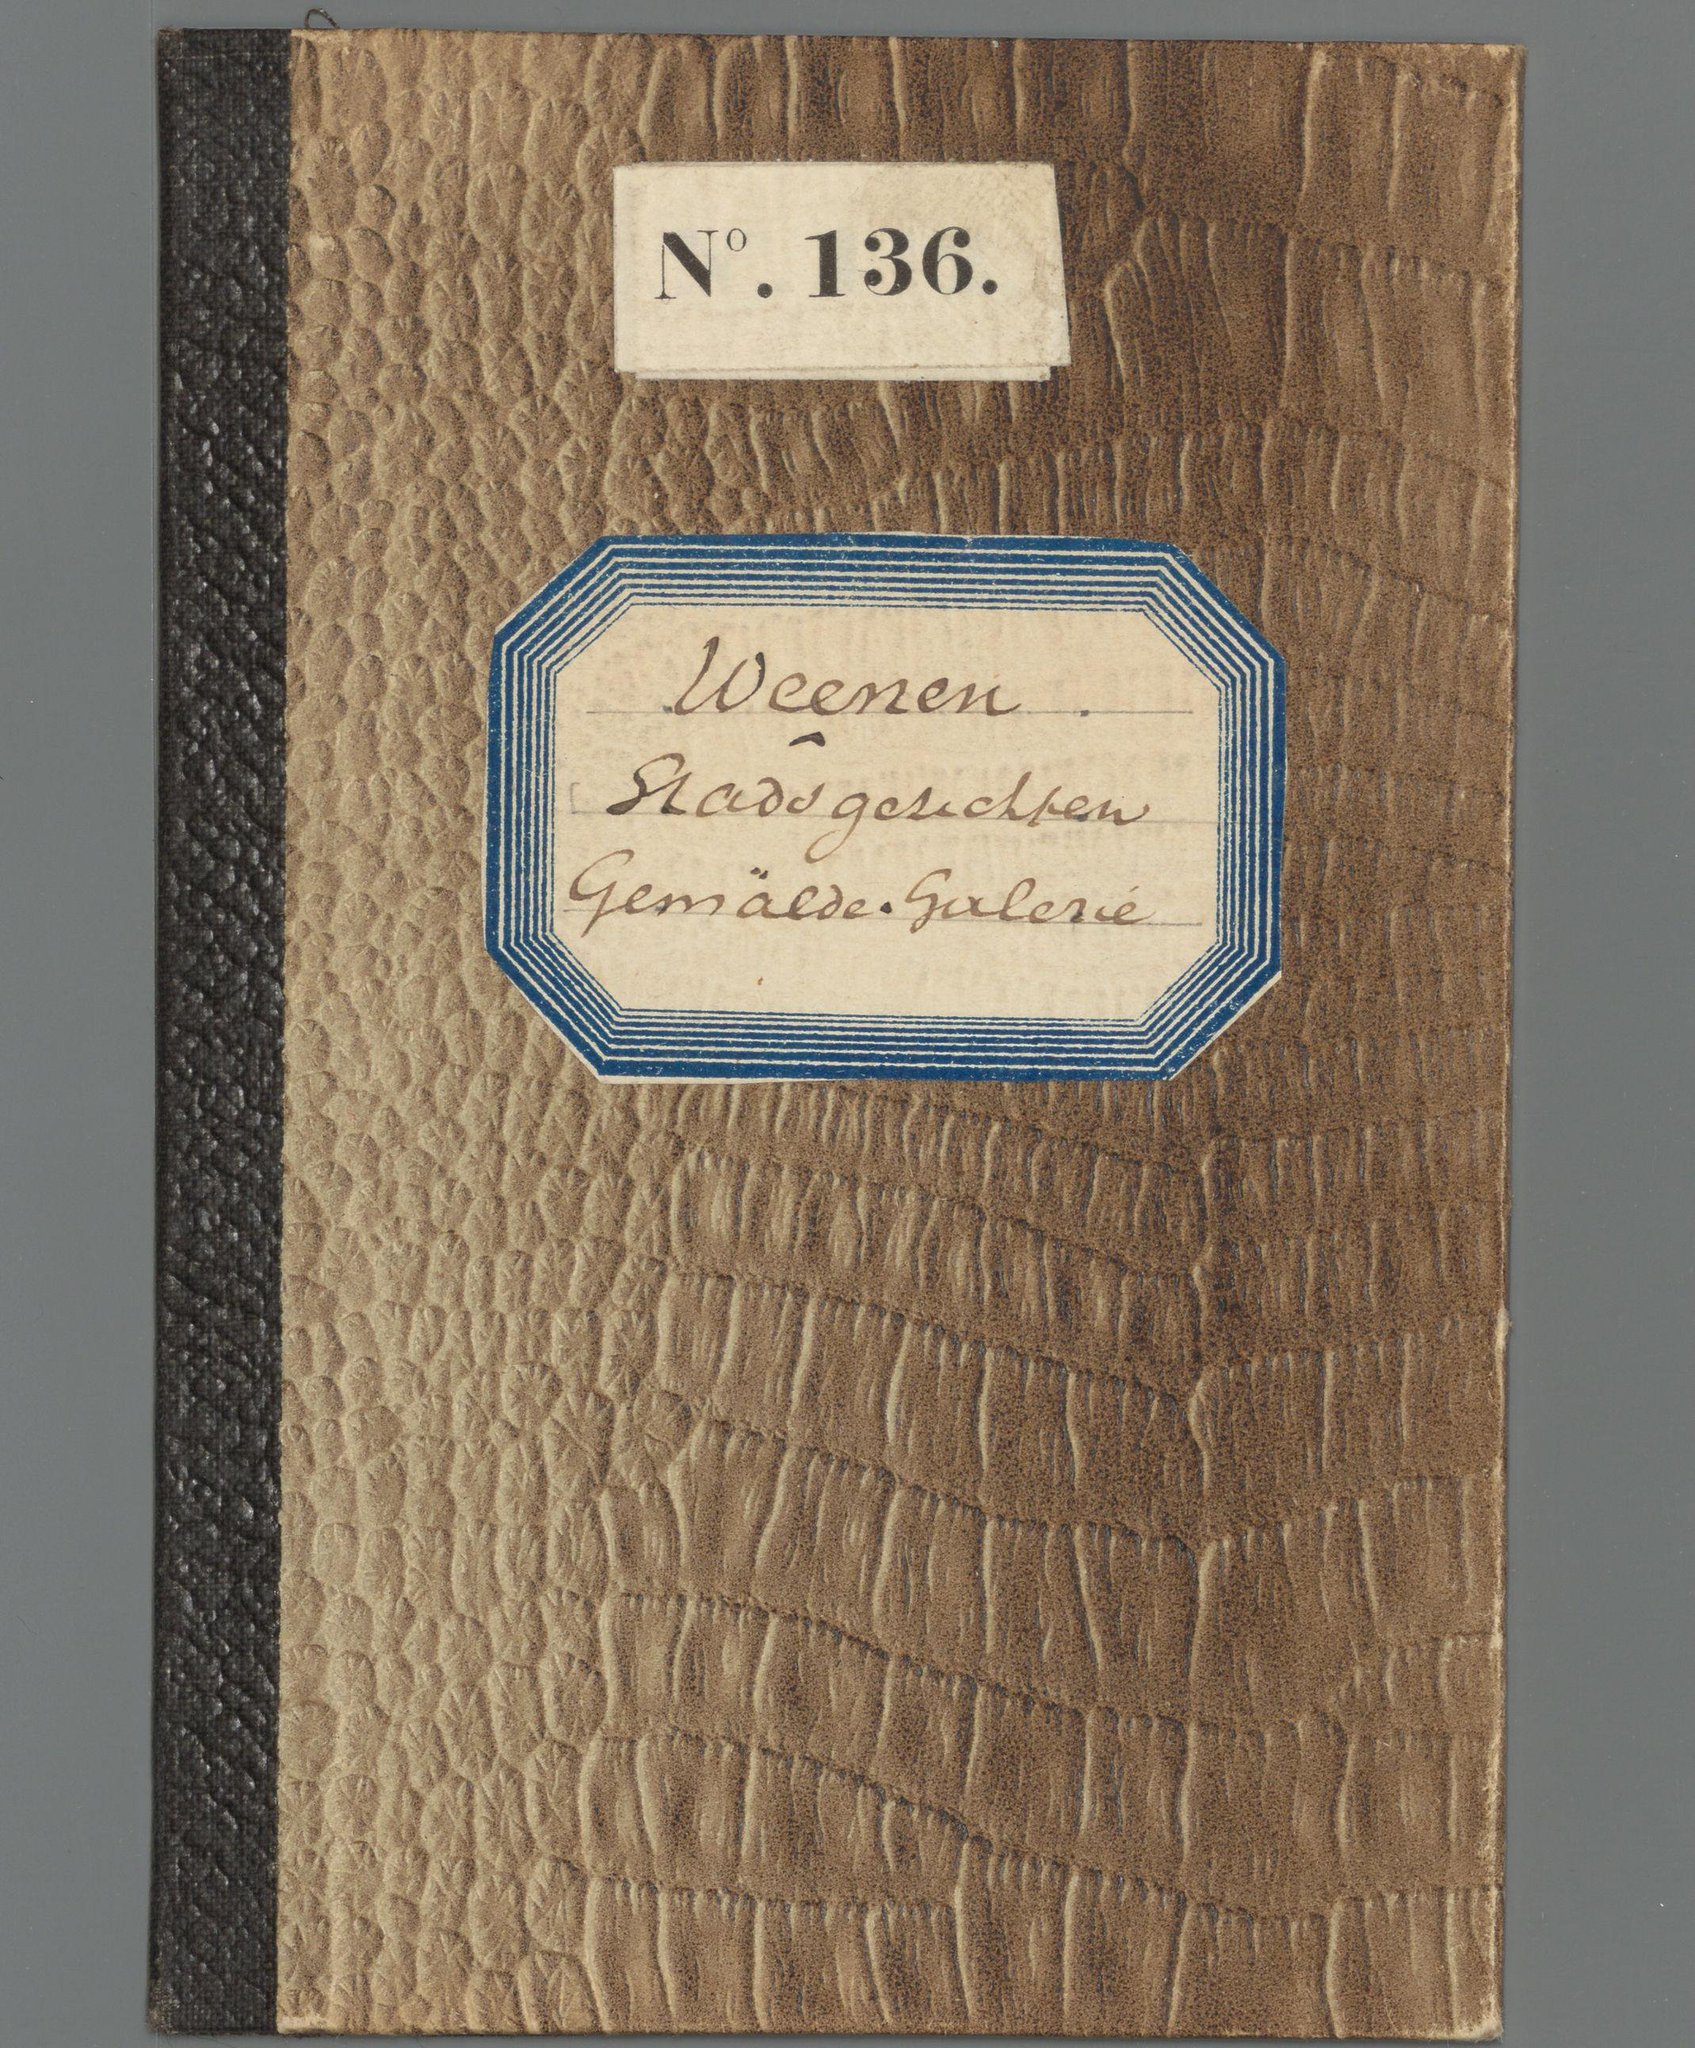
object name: wrapper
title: Omslag voor 24 prentbriefkaarten met gezichten uit Wenen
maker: Anonymous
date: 1900-1950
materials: cardboard, paper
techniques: lithograph, writing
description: In de omslag zit een kaart ingestoken met daarop een korte beschrijving van de inhoud.